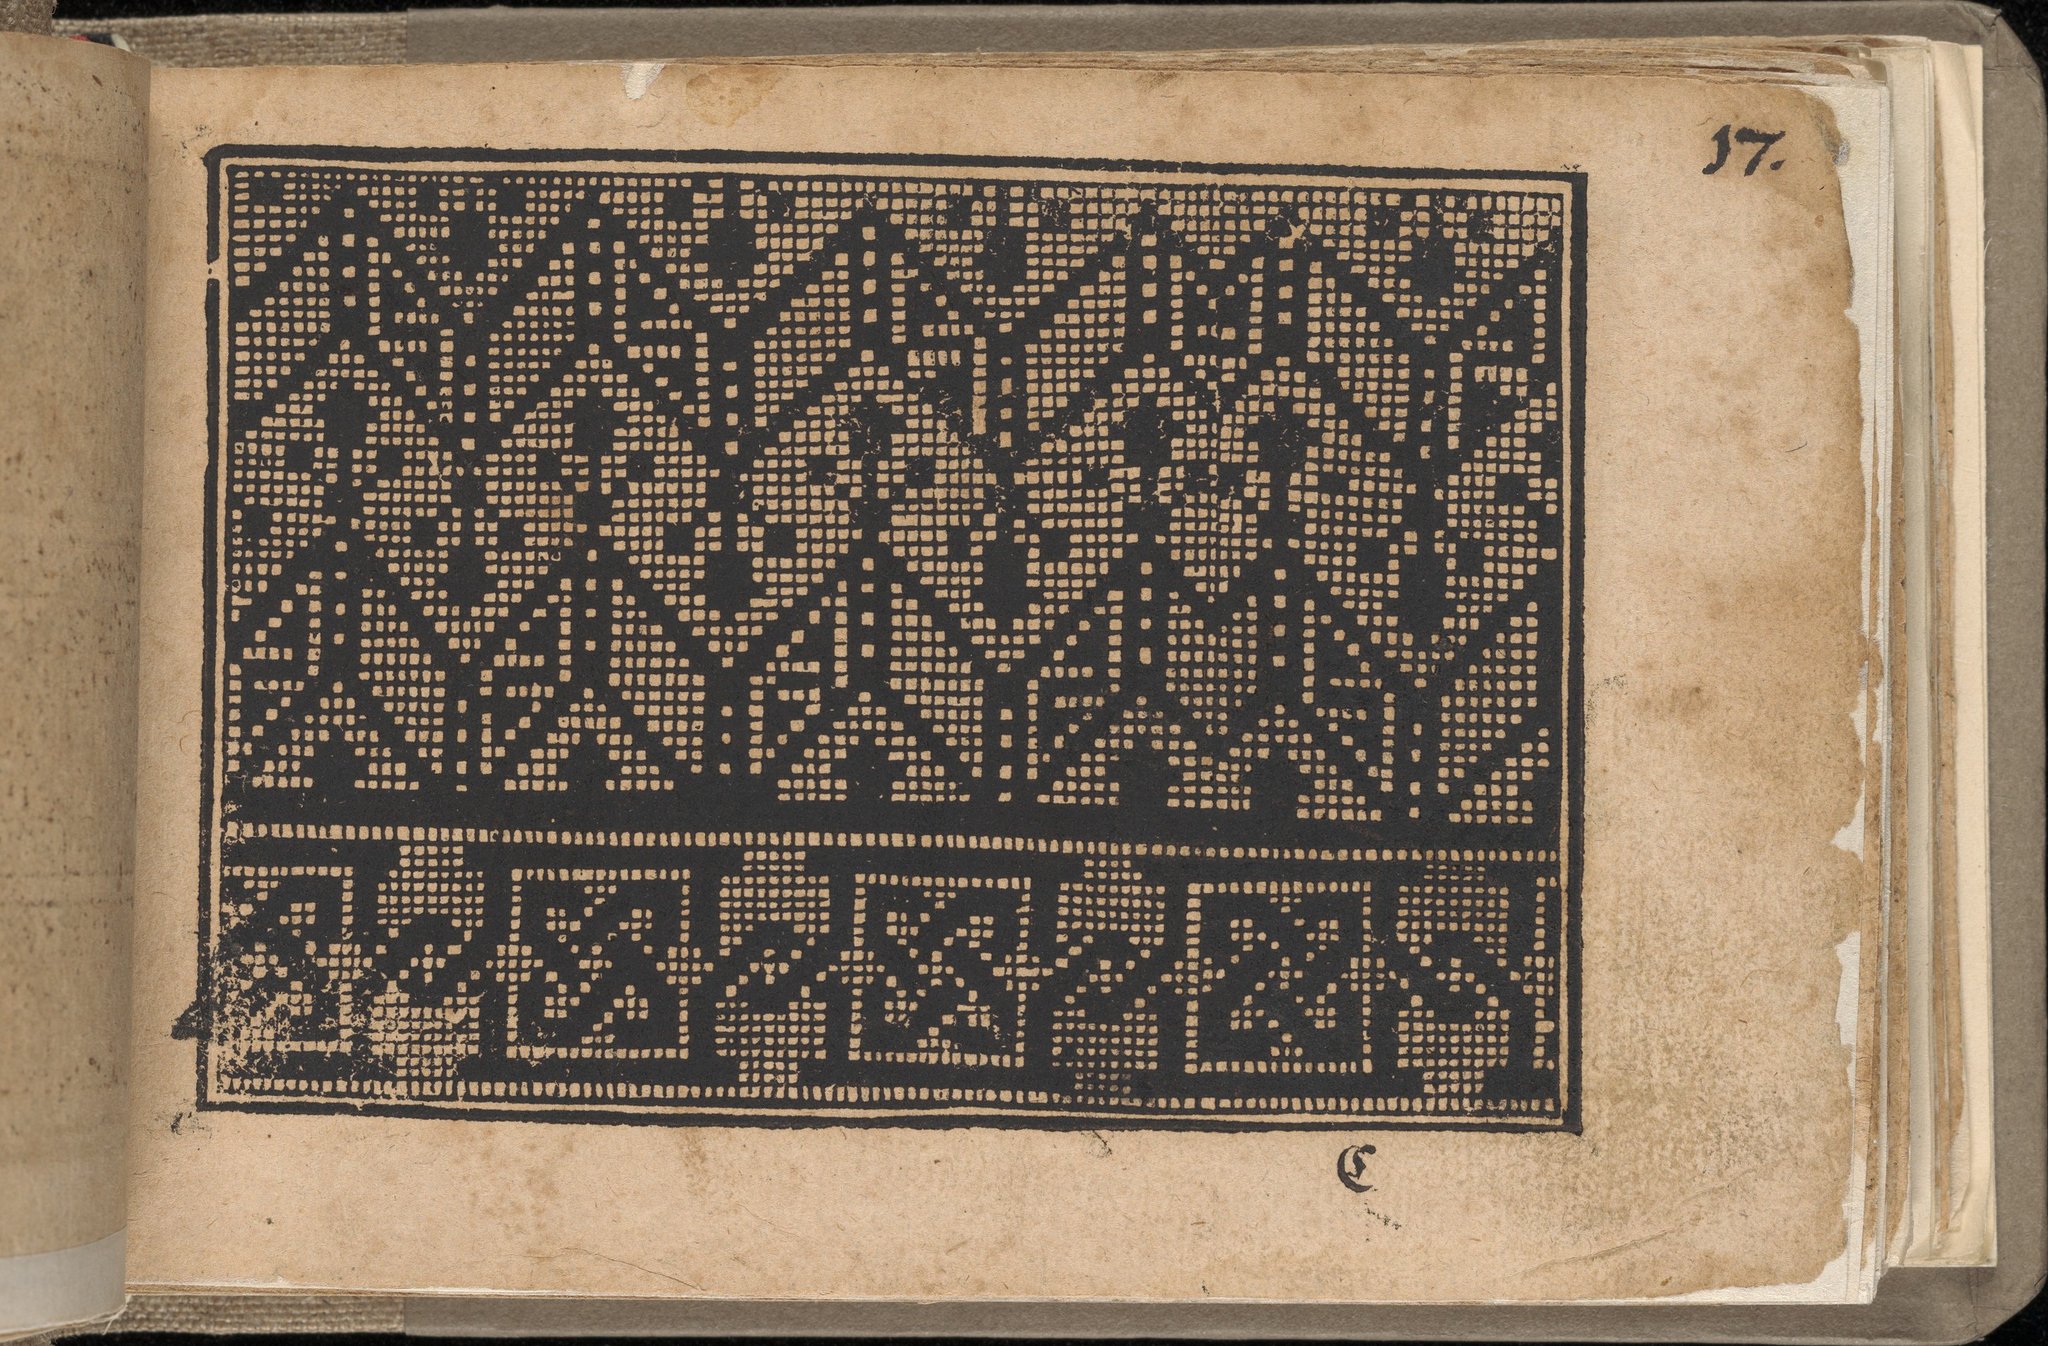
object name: book print ornament architecture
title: Schön newes Modelbuch (Page 17r)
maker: sigismundus latomus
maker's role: publisher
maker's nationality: german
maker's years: 1599-1632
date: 1608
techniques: woodcut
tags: ornament